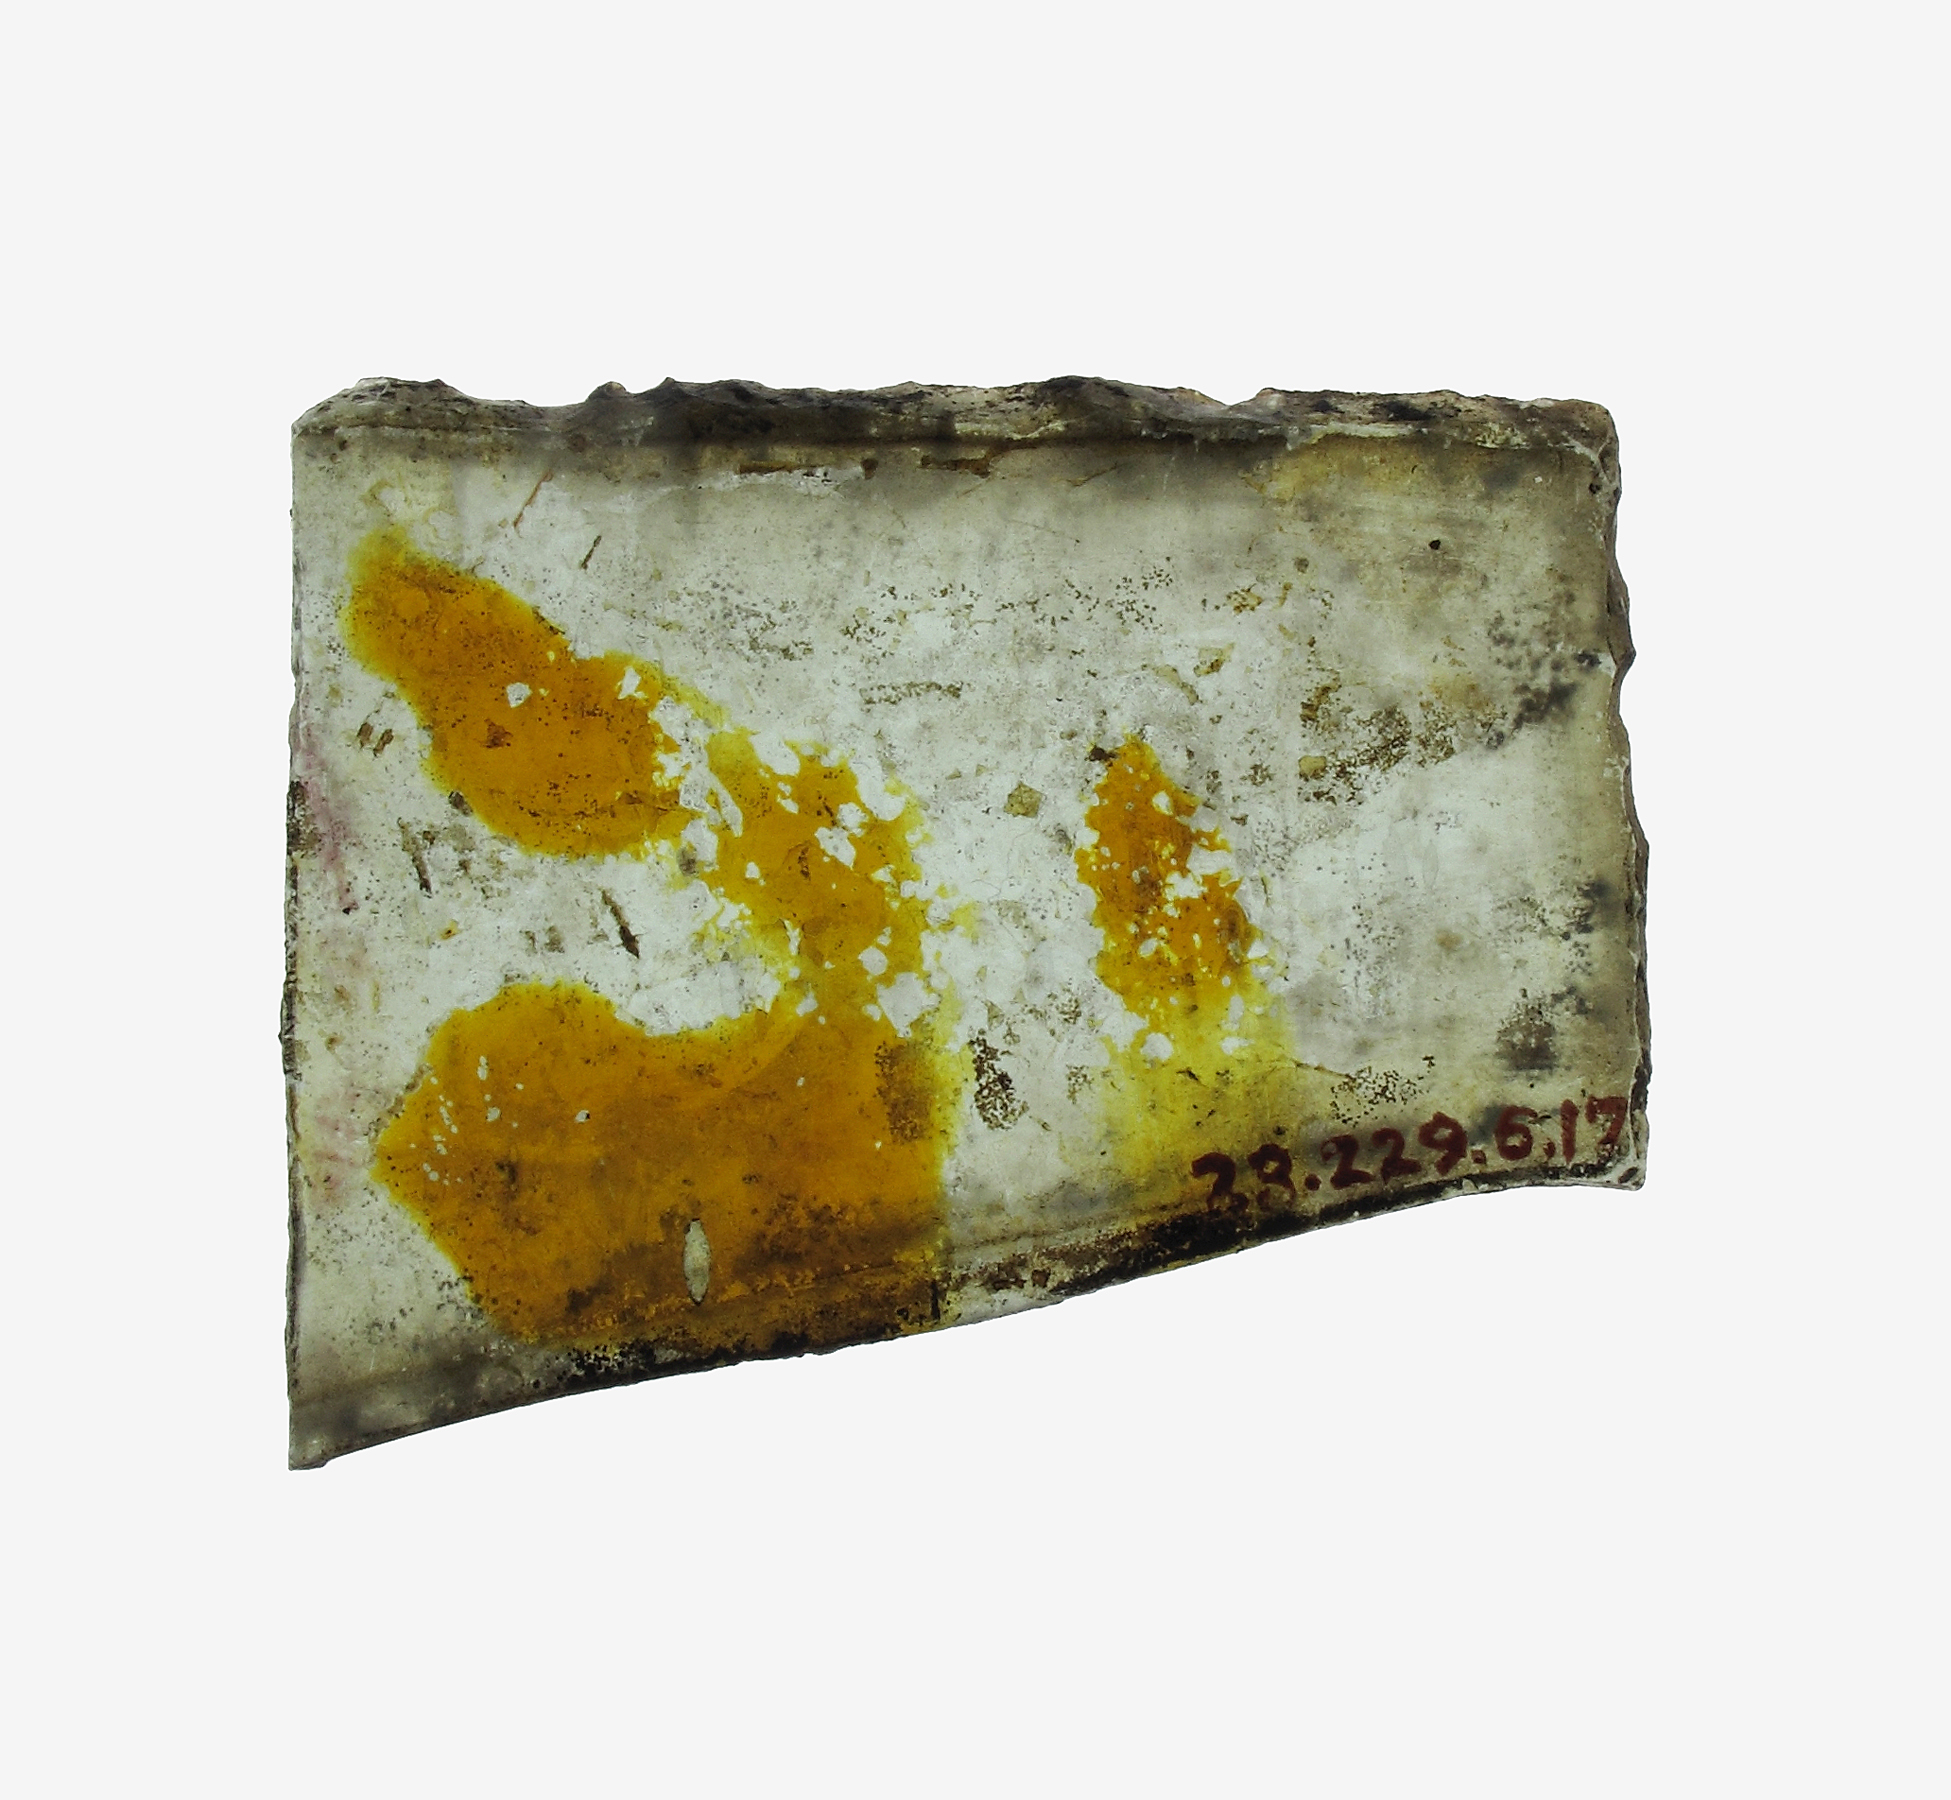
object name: fragment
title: Glass Fragment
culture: german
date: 1601-1700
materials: glass